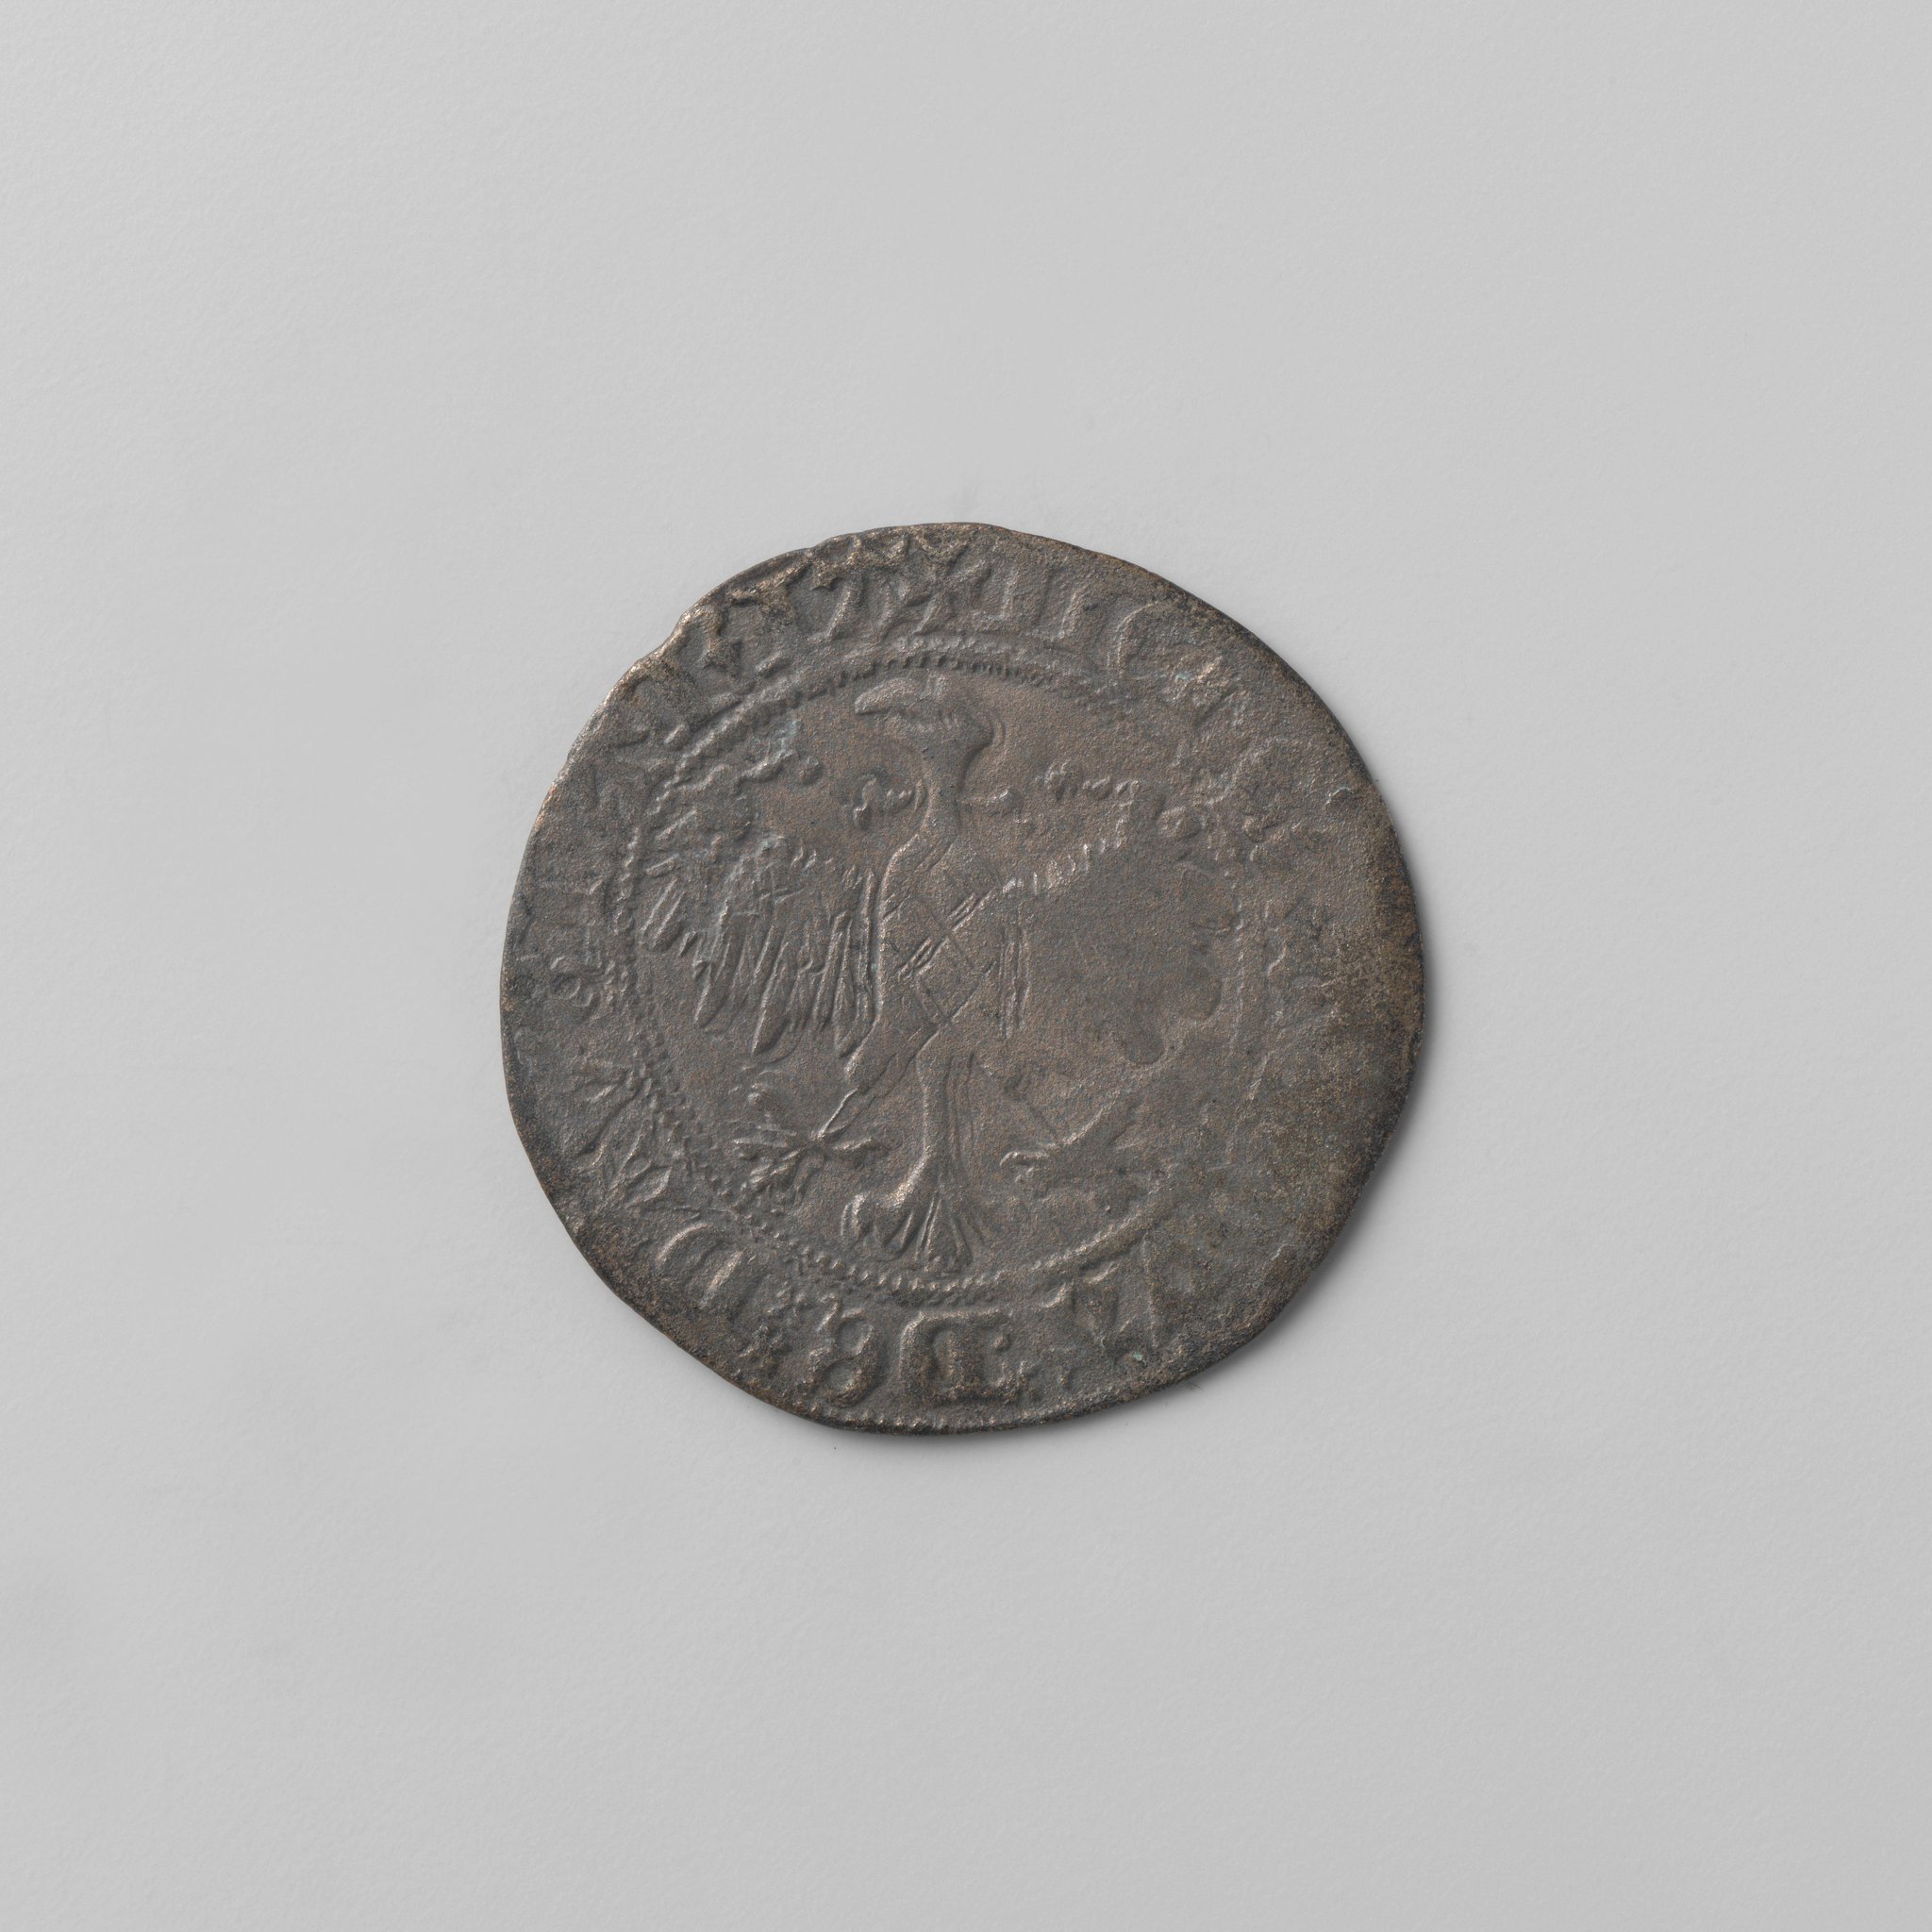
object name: coin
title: Utrechtse dubbele groot van Rudolf van Diepholt, 1433-1455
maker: rudolf van diepholt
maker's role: bisschop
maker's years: 1390-1455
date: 1433-1455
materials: silver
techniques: striking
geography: deventer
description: Zilveren munt. Voorzijde: wapenschild van Diepholt op lang gevoet kruis. Keerzijde: adelaar.